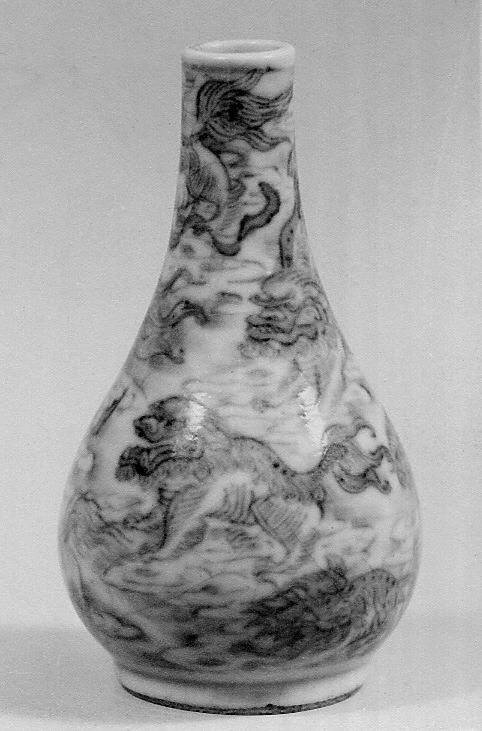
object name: snuff bottle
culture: chinese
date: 1723-1735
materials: porcelain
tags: animals